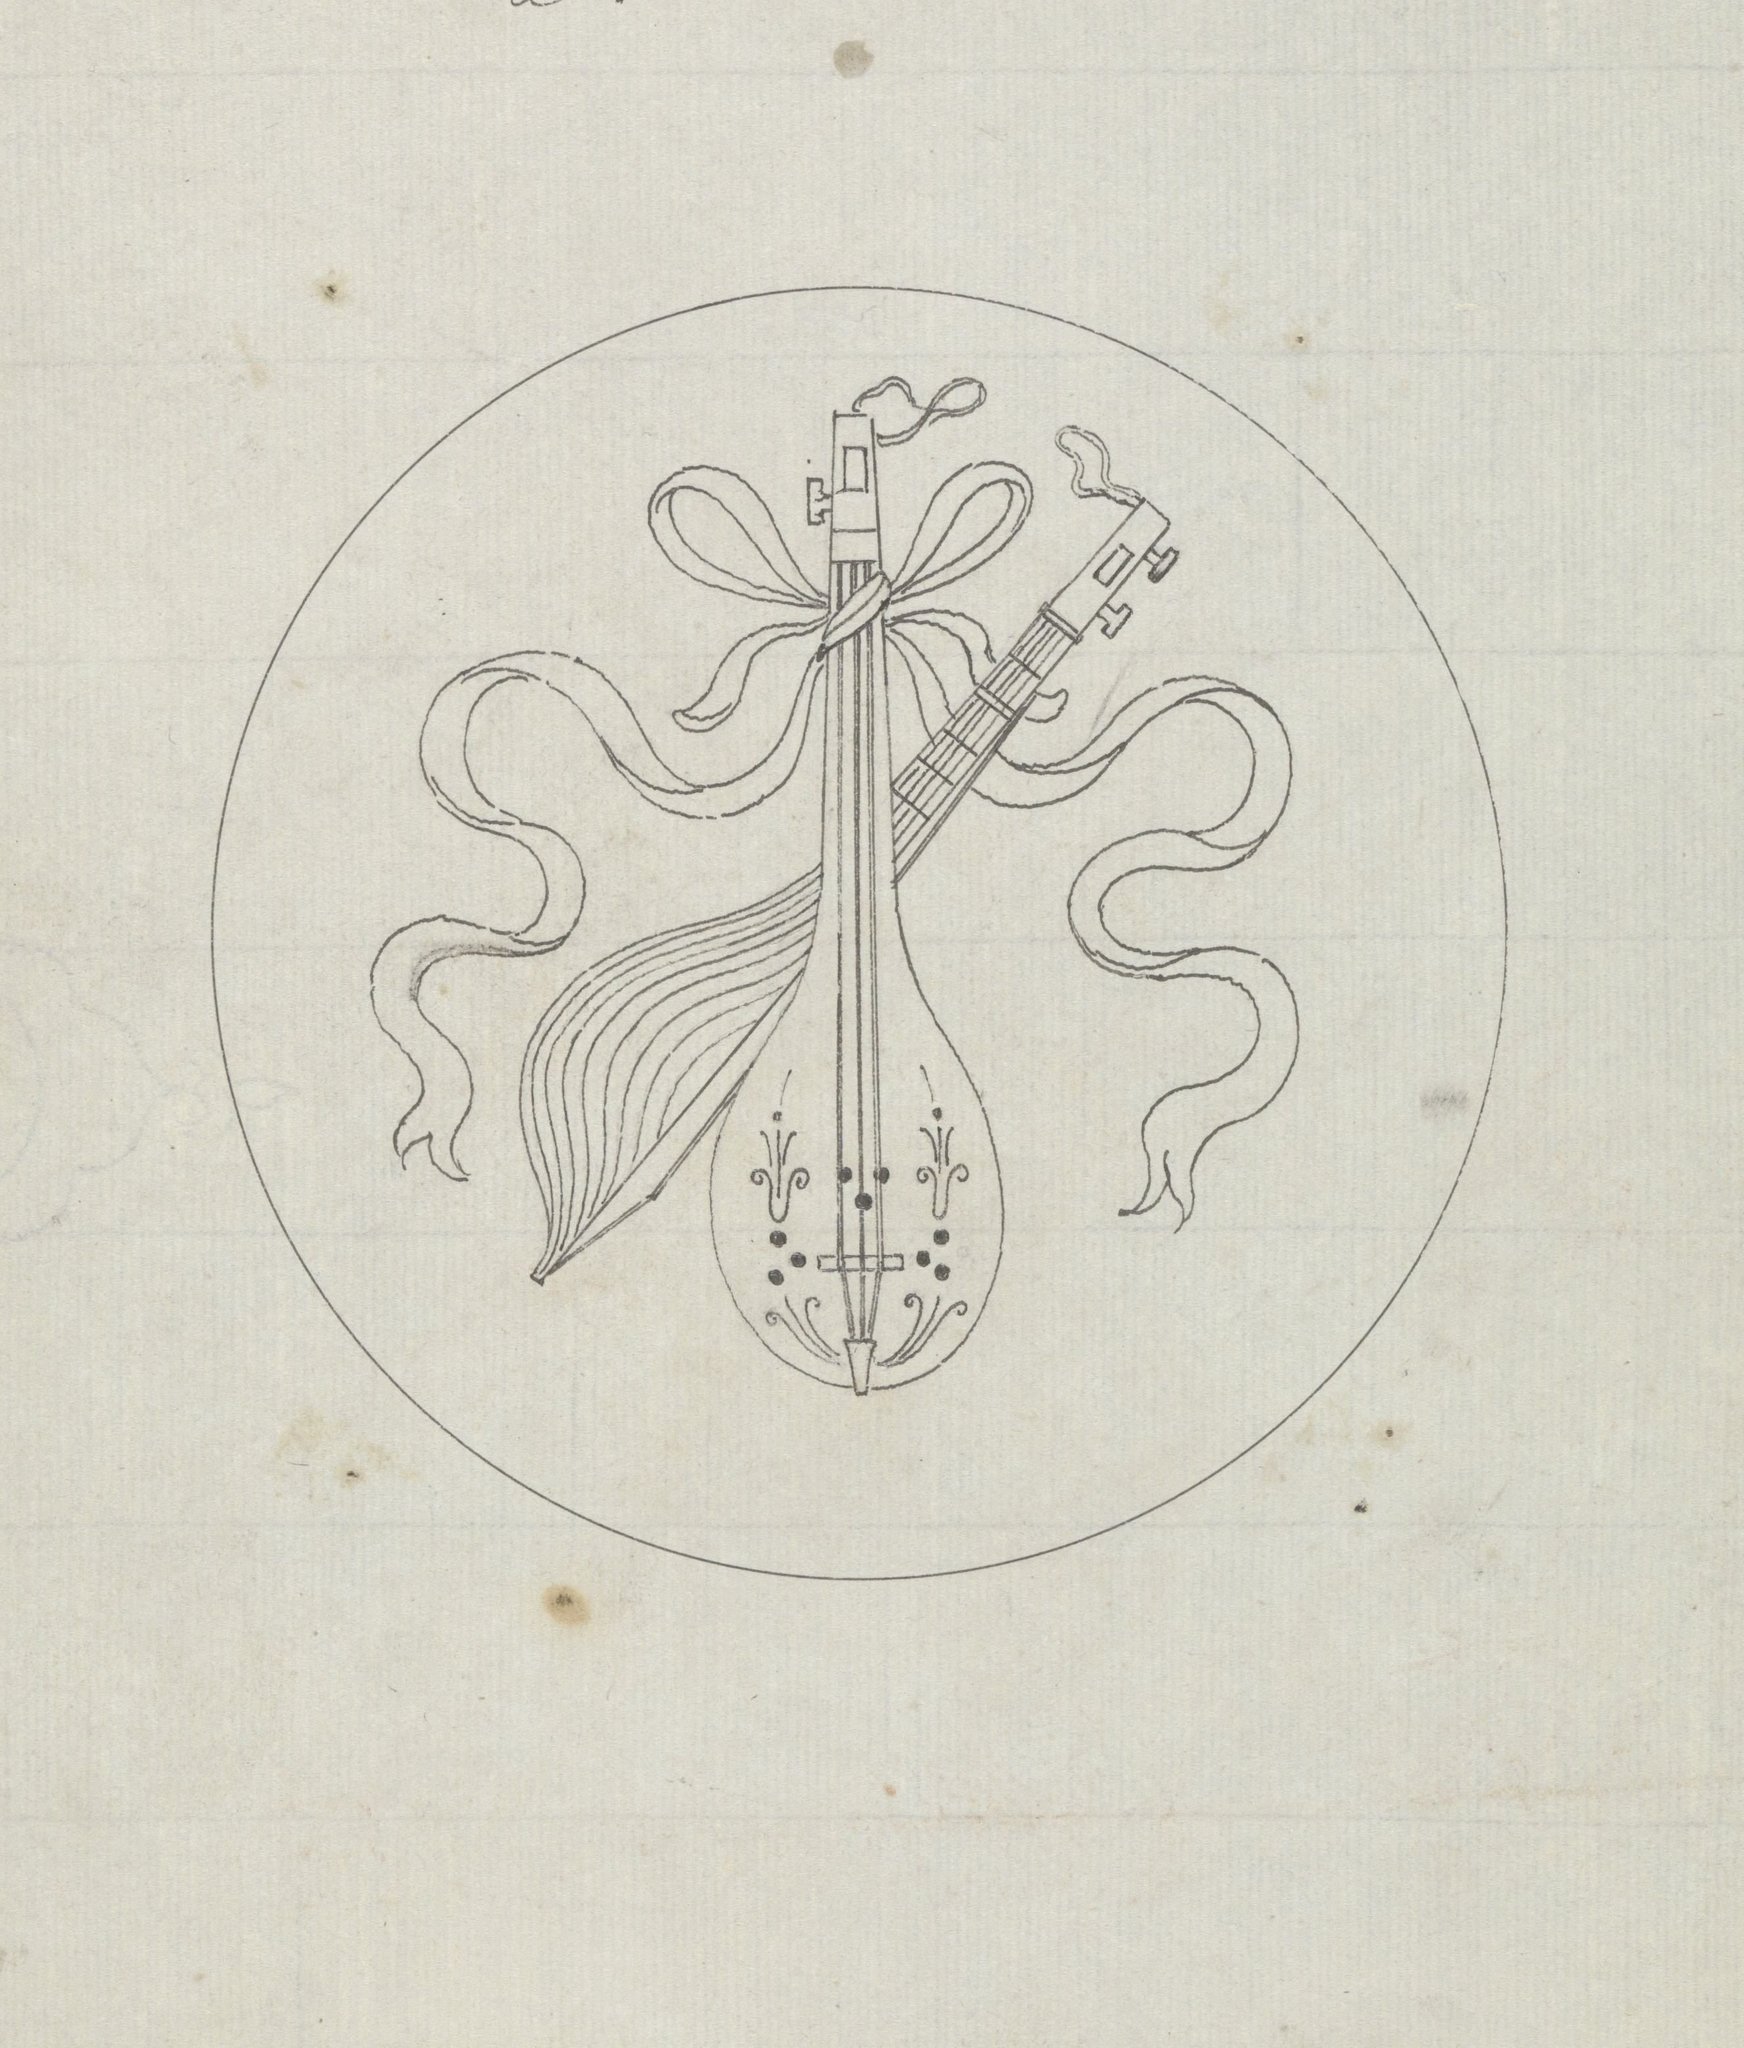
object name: design drawing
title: Ontwerp voor marqueterie van aan linten opgehangen muziekinstrument(en) in rond medaillon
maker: pierre félix van doren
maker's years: 1797-1856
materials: graphite, ink, paper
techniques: pen in black ink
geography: brussels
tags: trophy, i.e.: decorative arrangement of symbolic or typical objects ~ ornament, string instruments (plucked)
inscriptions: watermark, inscription: ‘le Tambour Arabe’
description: Een van 103 ontwerpen voor marqueterie van aan linten opgehangen muziekinstrumenten in ronde medaillons, bestemd voor de set stoelen gemaakt door Van Doren voor de grote zaal van het Paleis van de Prins van Oranje in Brussel in 1828.